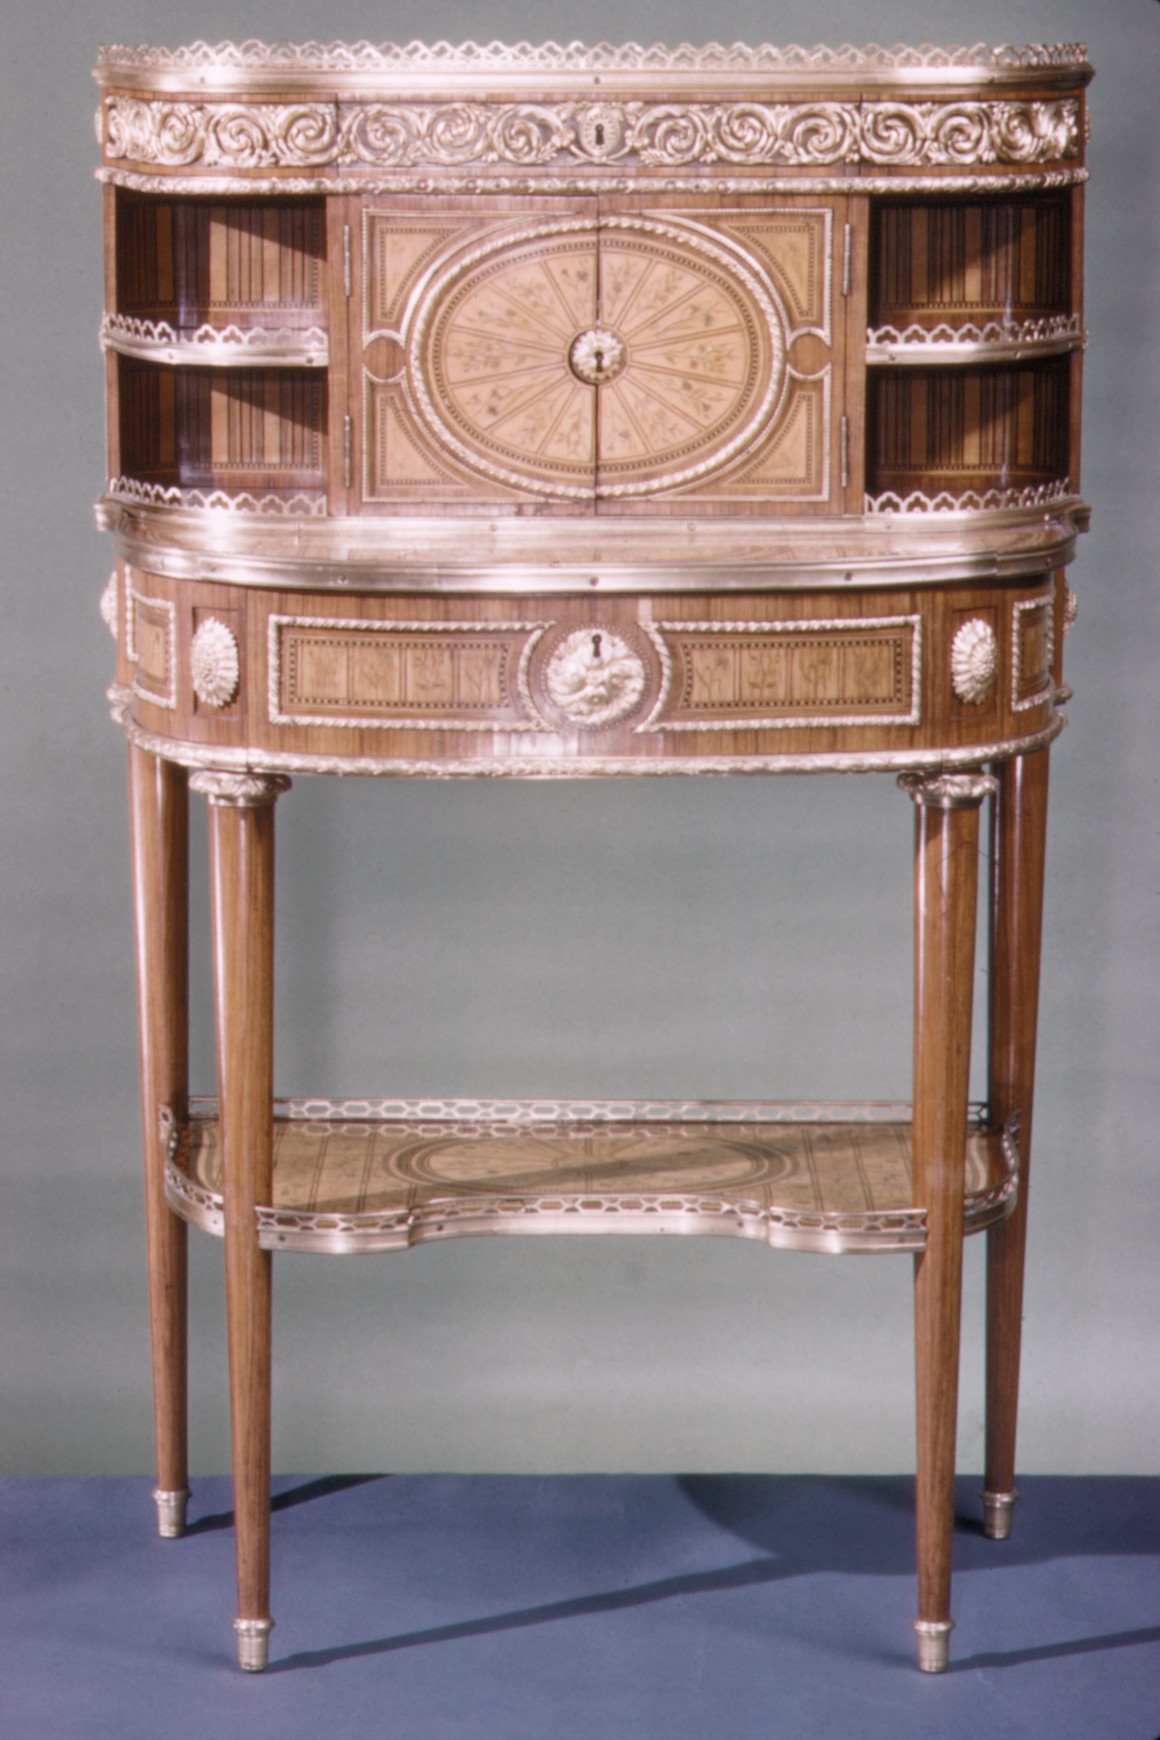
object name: desk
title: Desk (bonheur du jour)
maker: roger vandercruse, called lacroix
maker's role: maker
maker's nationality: french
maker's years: 1727-1799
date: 1780-1785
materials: gilt bronze, wood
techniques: stain